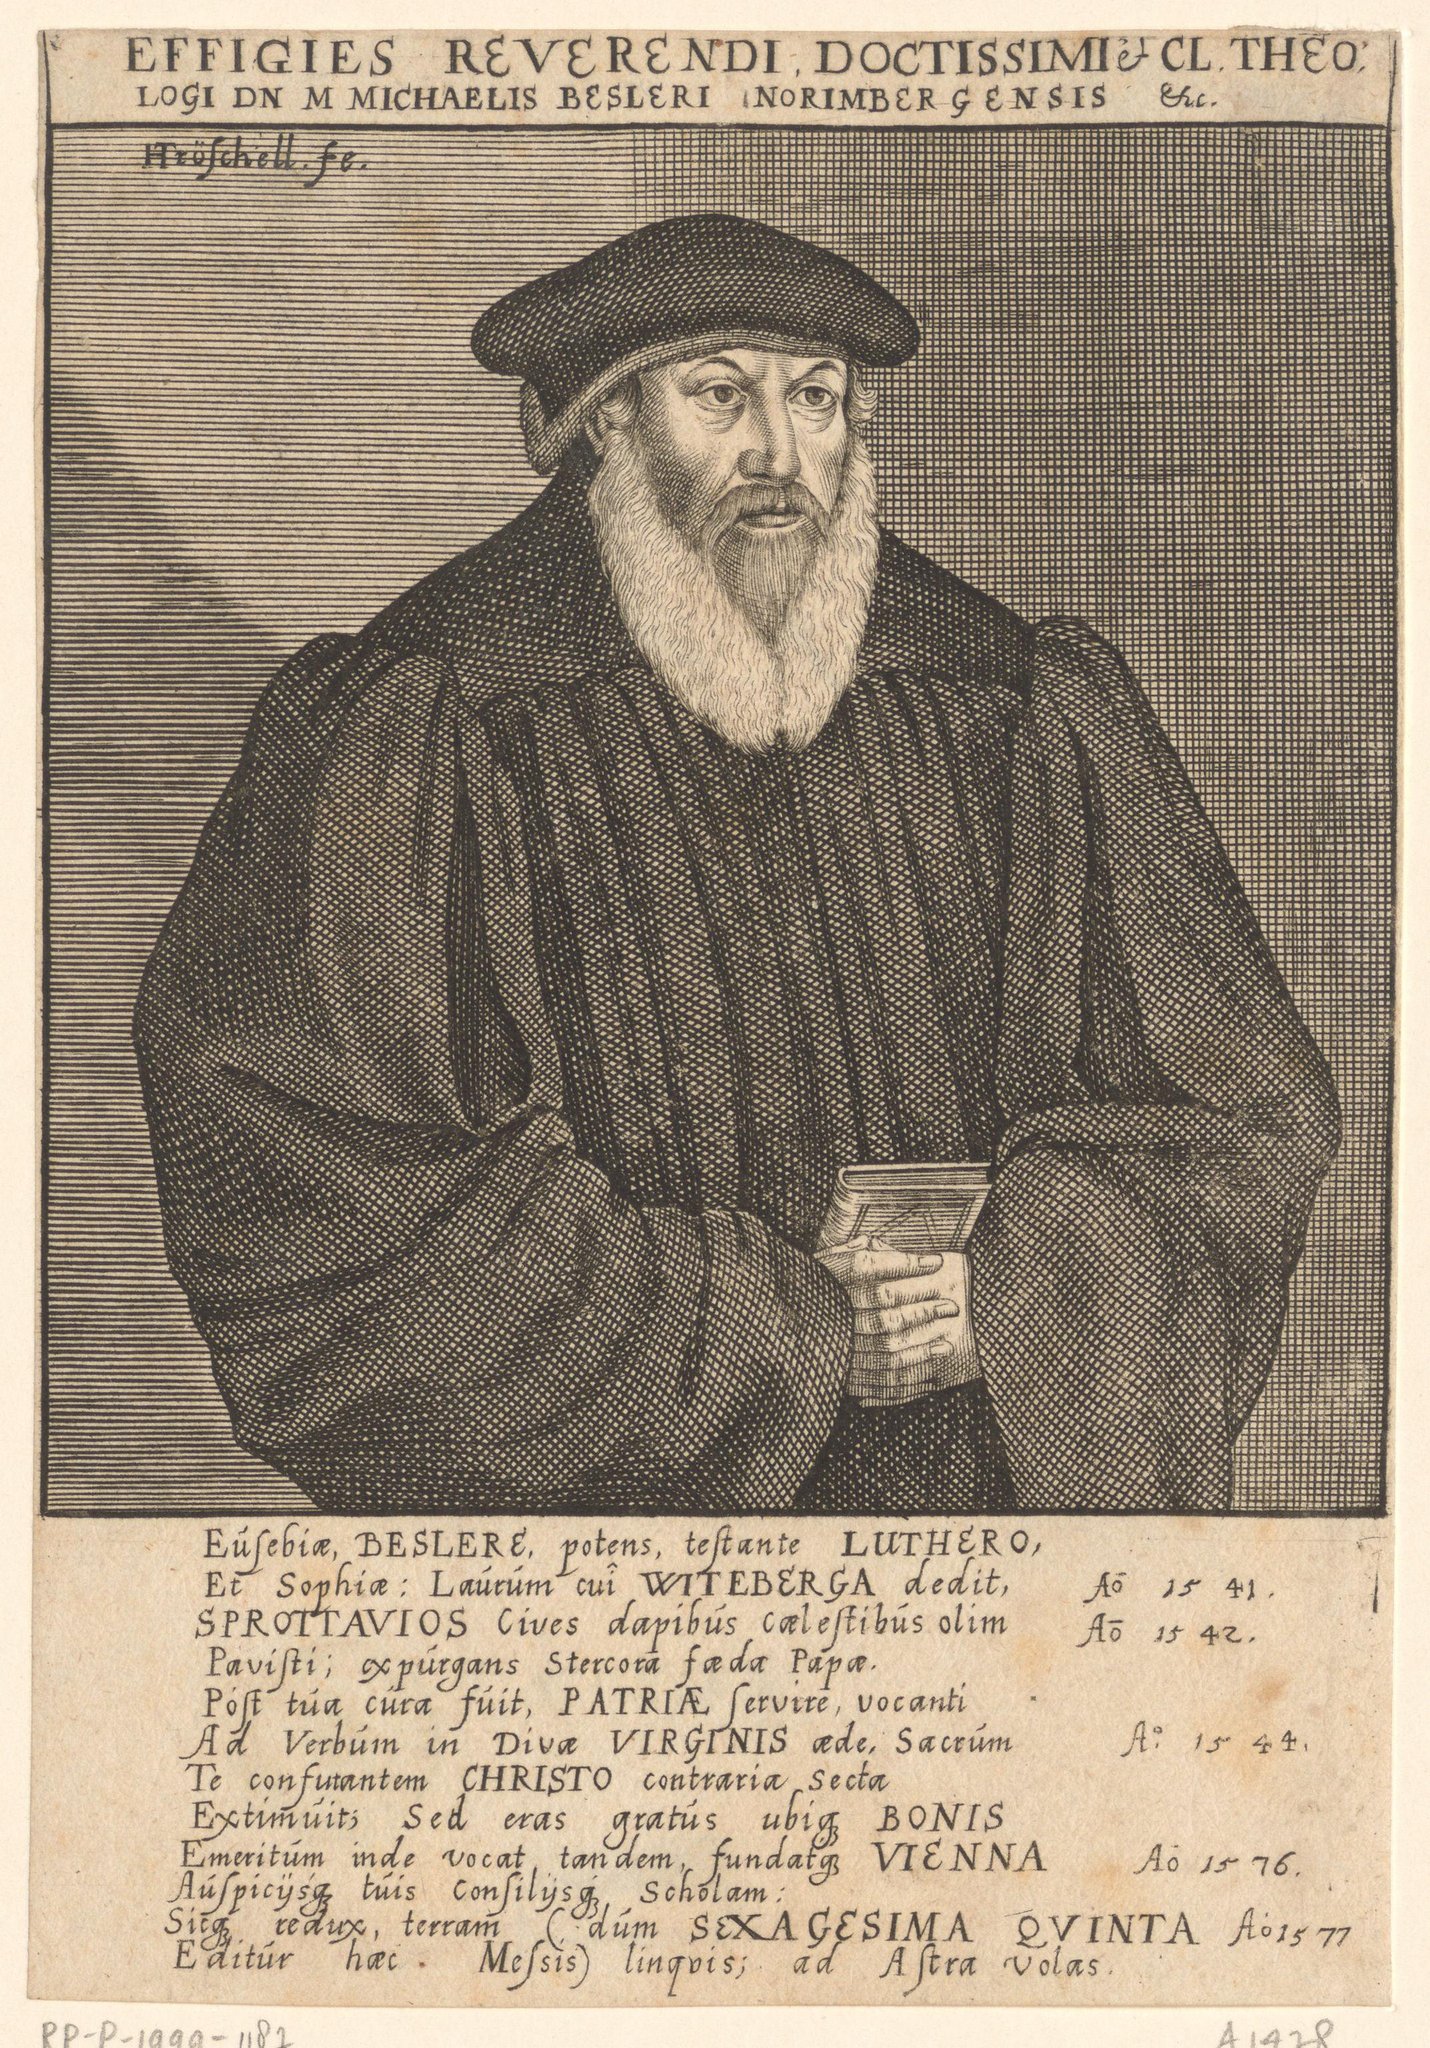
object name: print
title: Portret van Michael Besler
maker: hans troschel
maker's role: draughtsman, print maker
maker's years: 1585-1628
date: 1595-1628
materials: paper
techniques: engraving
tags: theologian, historical persons, book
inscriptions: collector's mark: Lugt 2228, collector's mark: Lugt 1615, collector's mark: Lugt 2760, collector's mark: Lugt 2481a